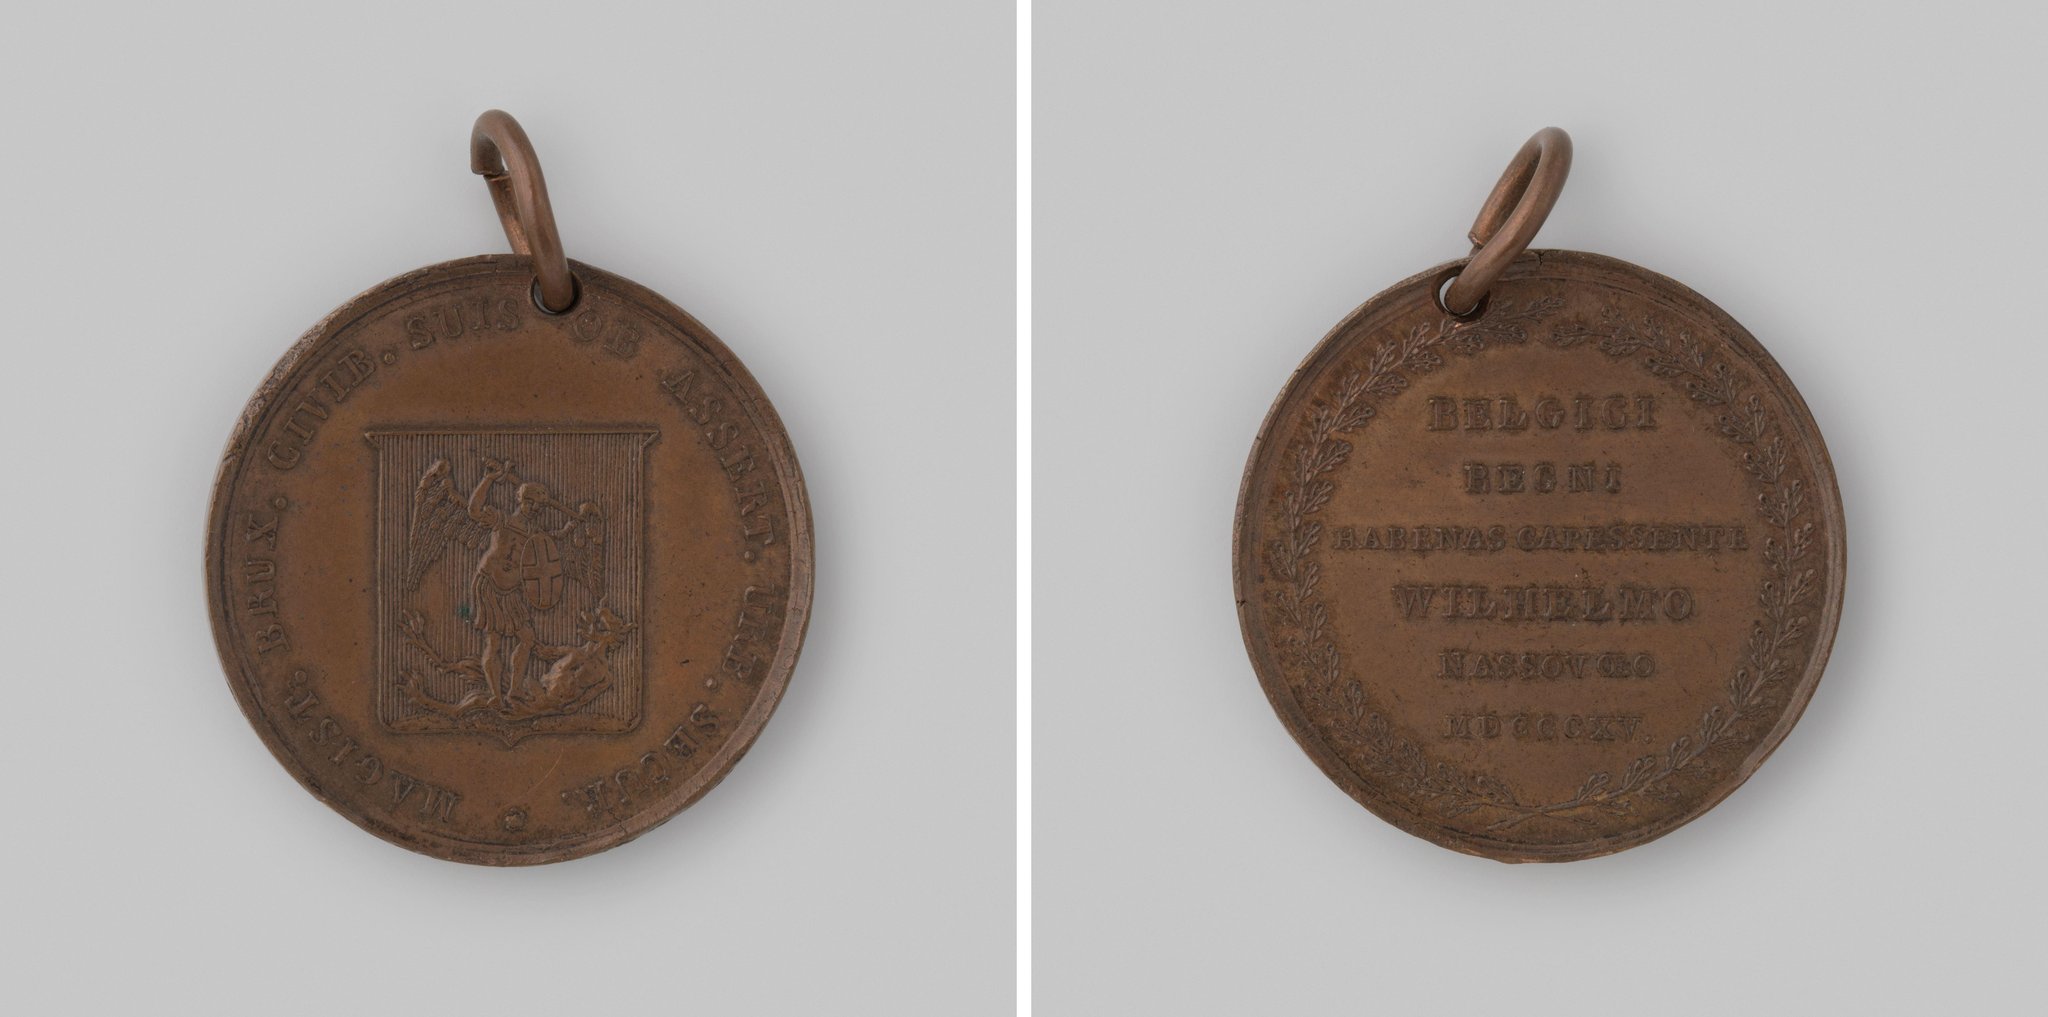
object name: honorary medal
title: Erepenning voor de schutterij van Brussel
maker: Anonymous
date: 1815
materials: bronze